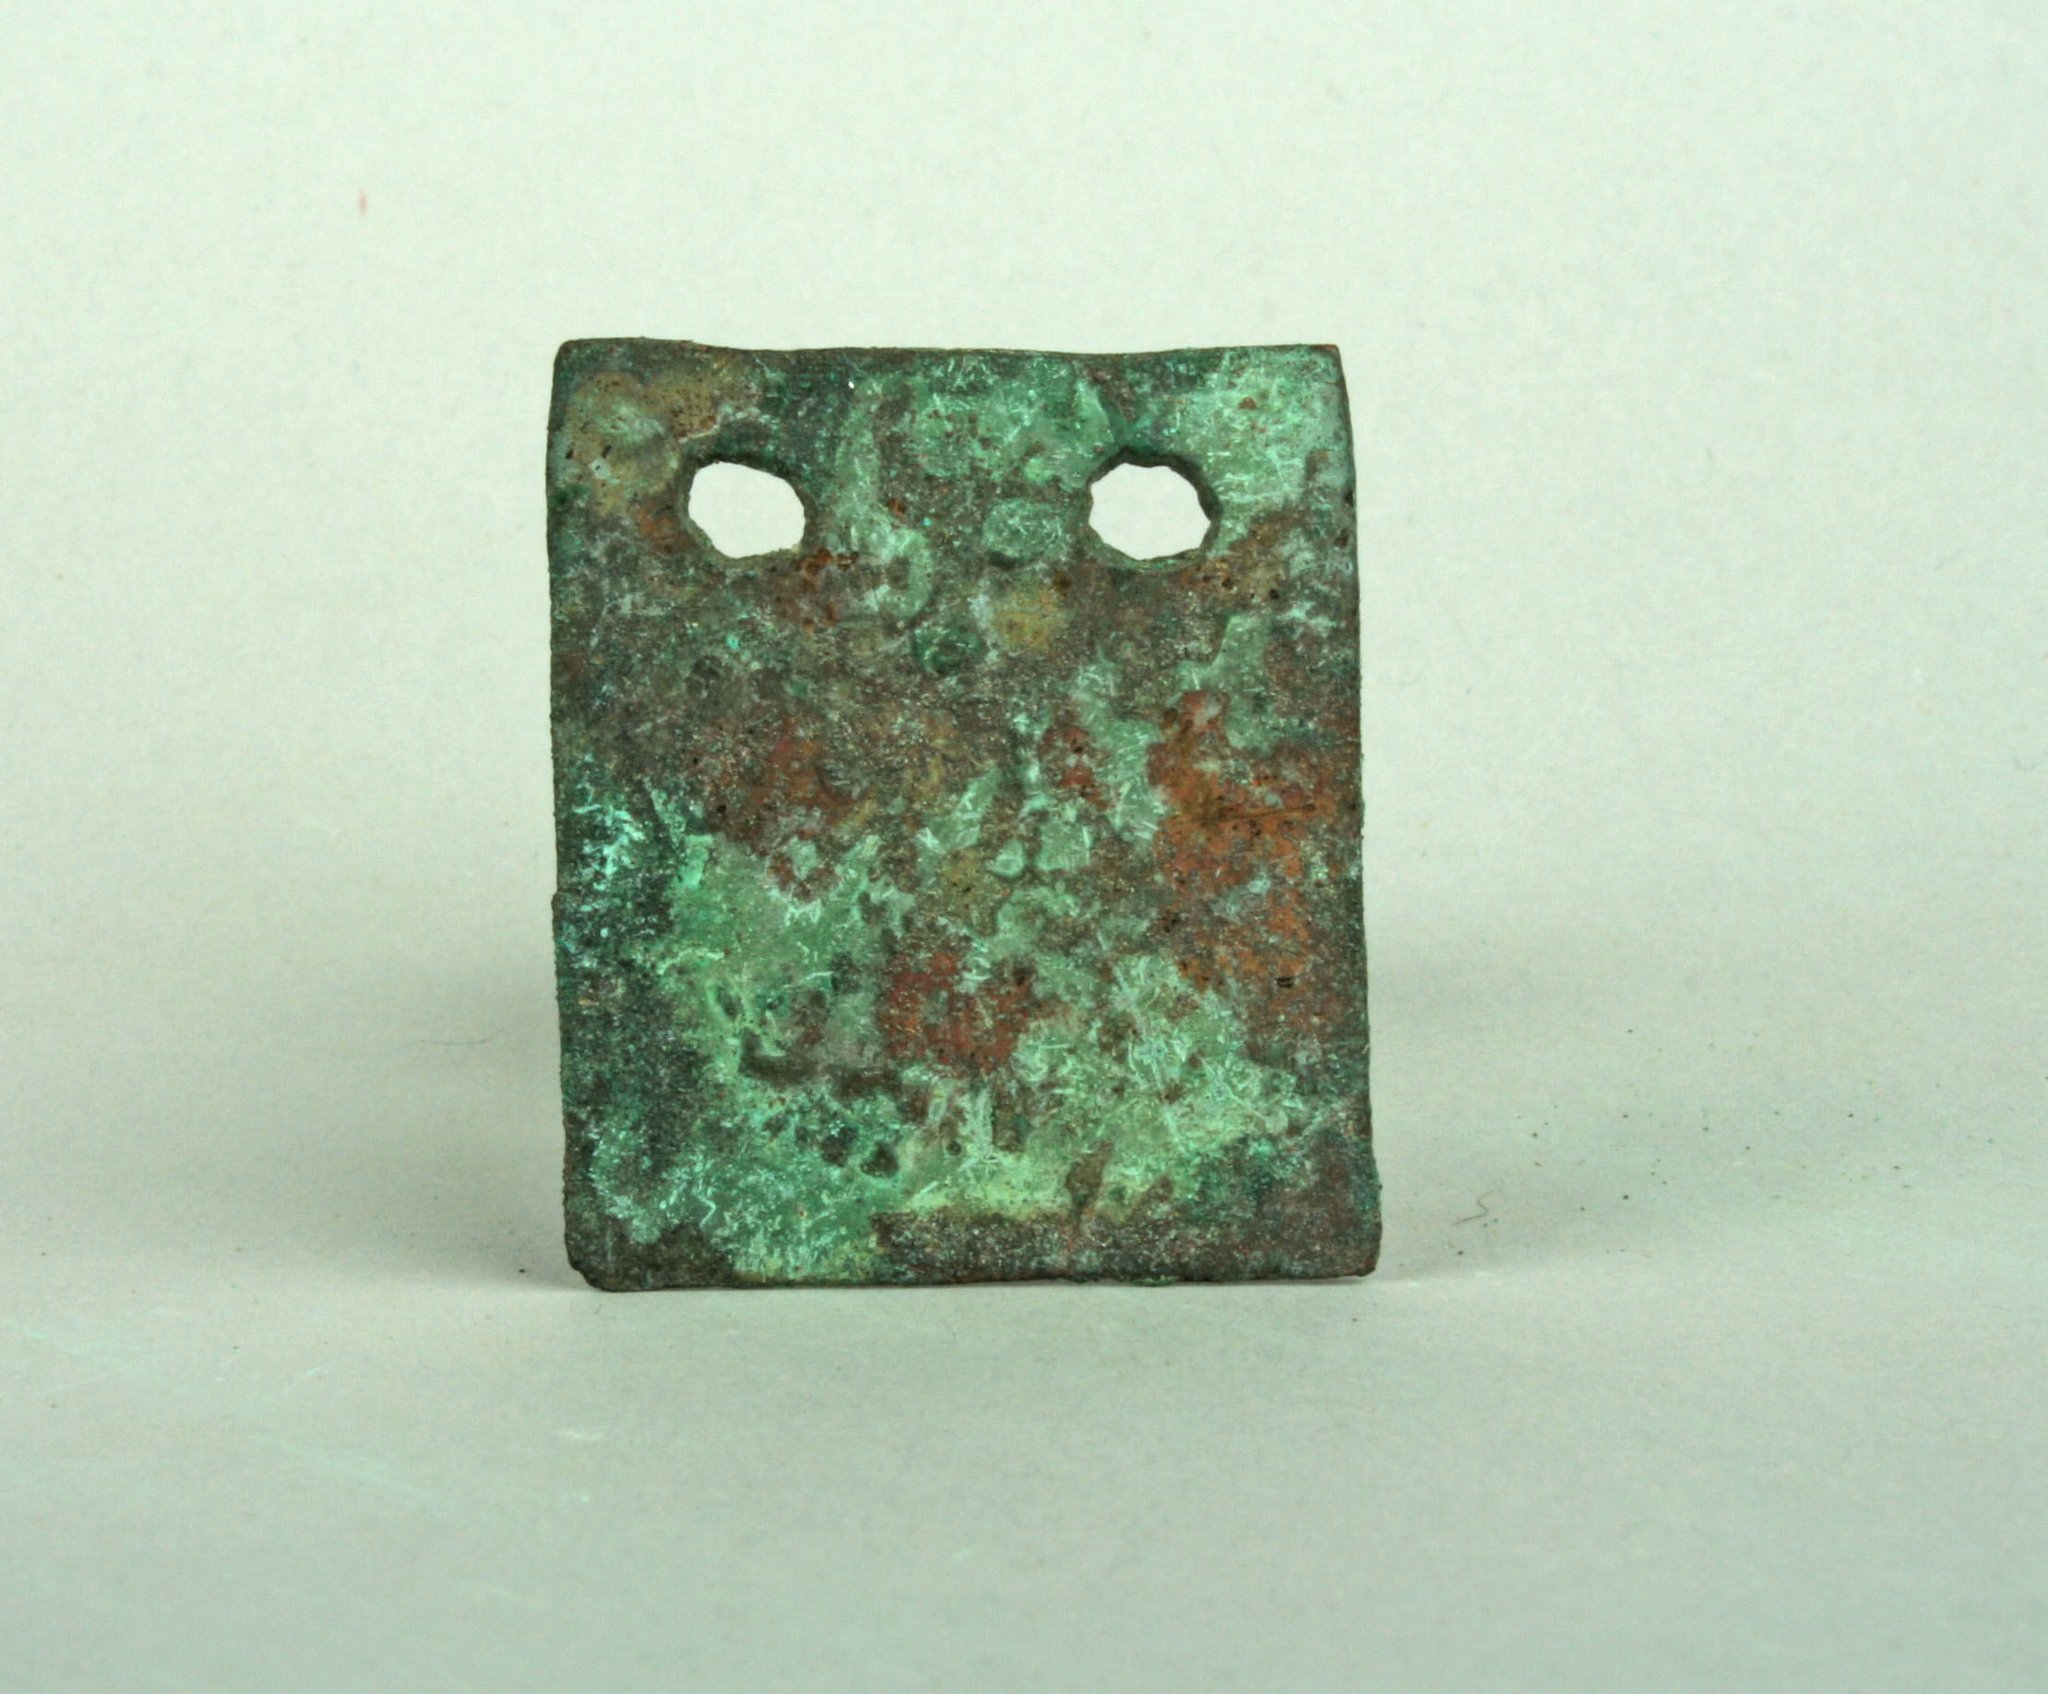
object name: plaque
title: Square Plaque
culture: vicús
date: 300 BCE-200 CE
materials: copper, gilt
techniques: hammering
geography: peru